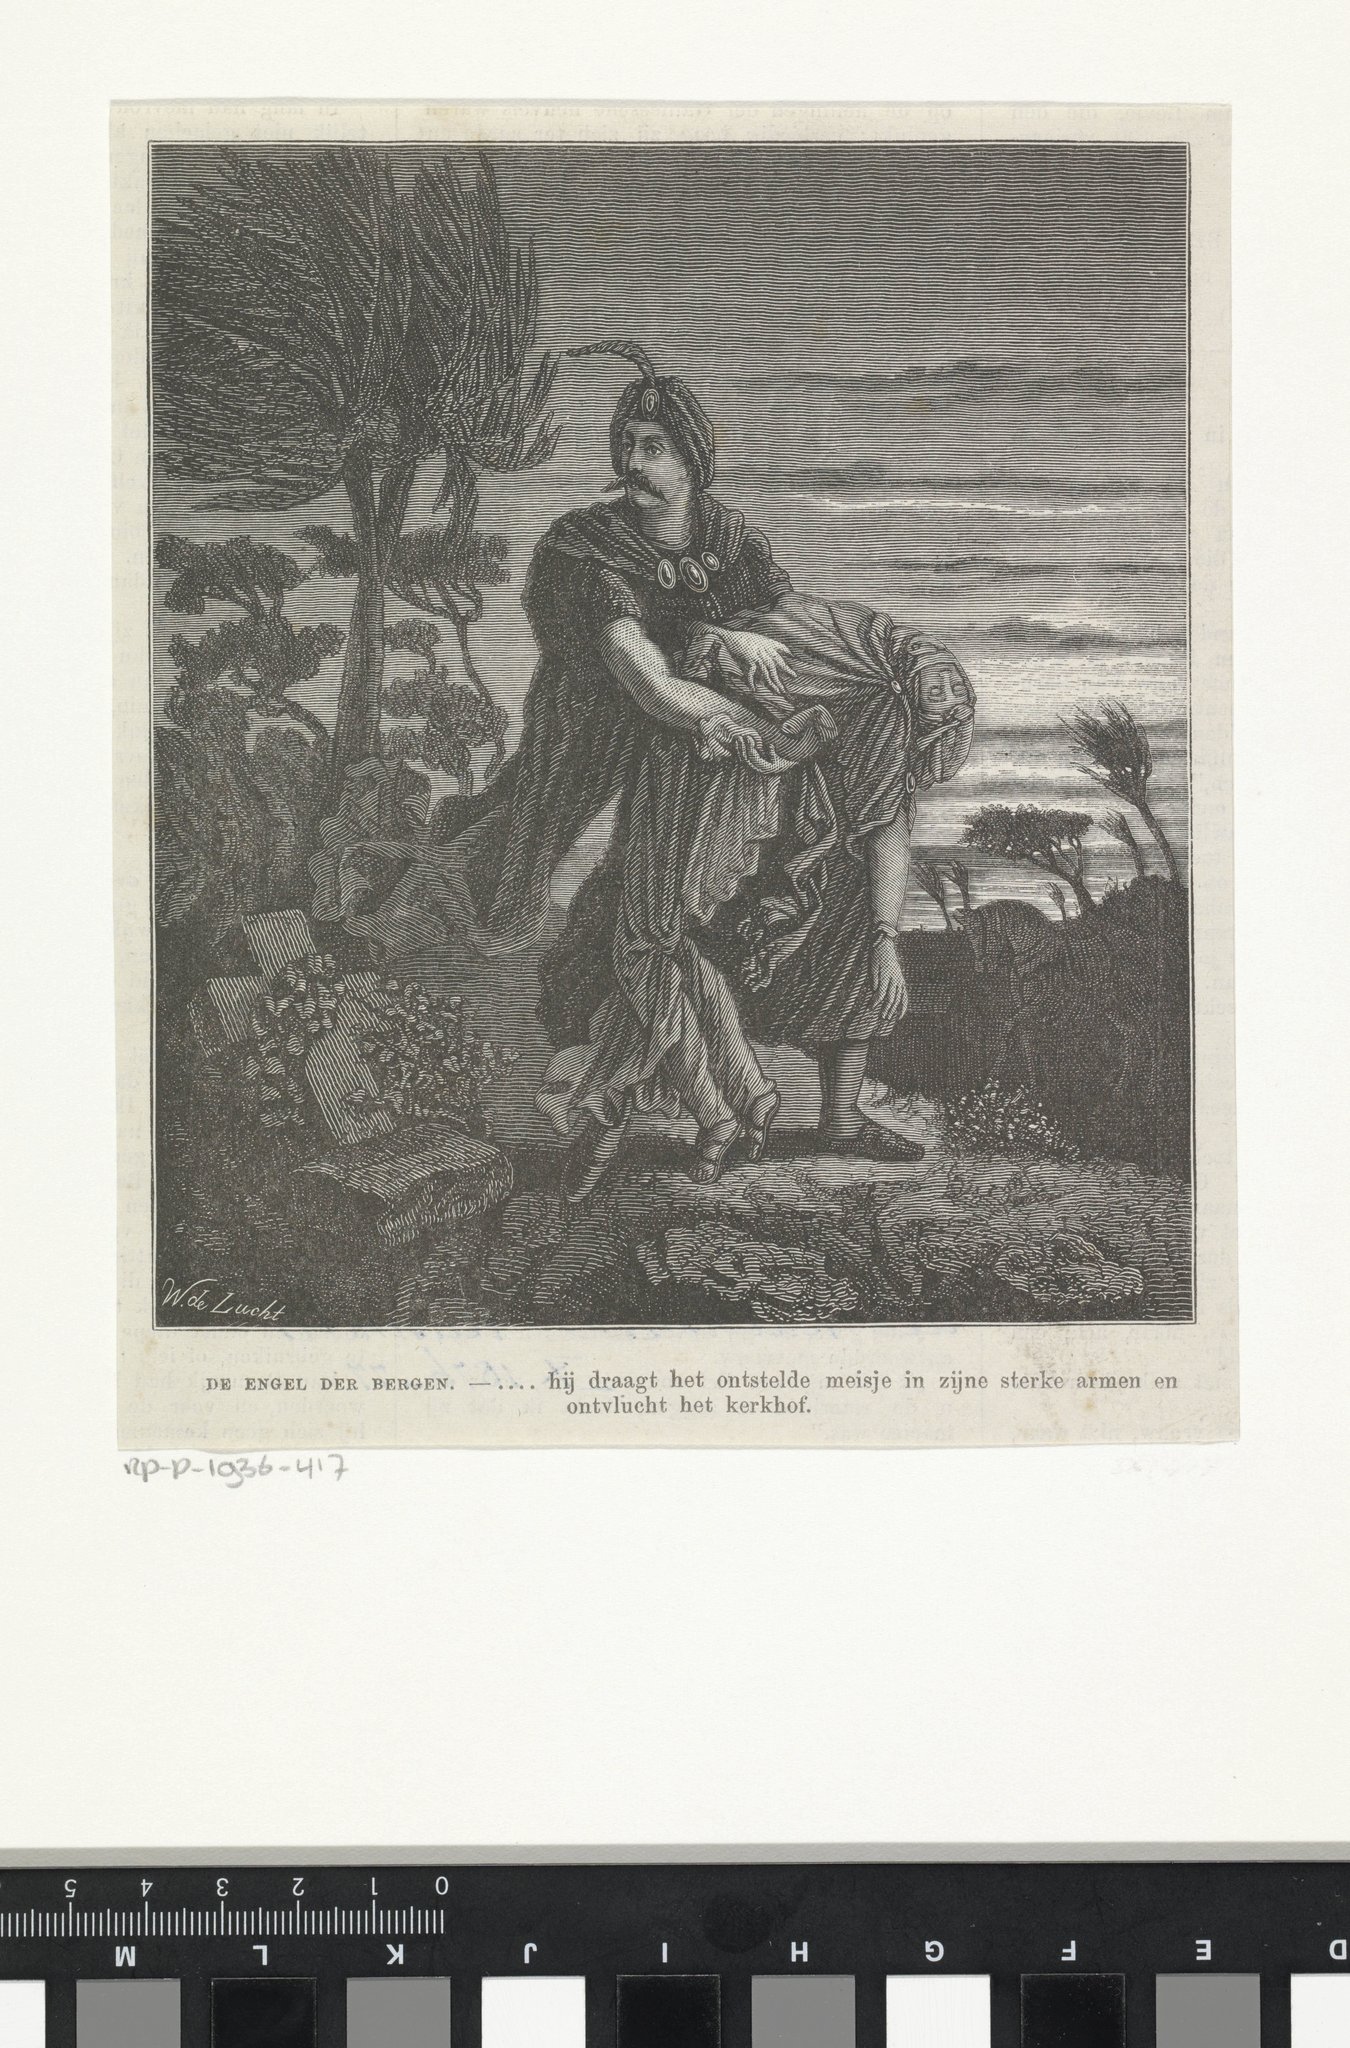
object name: print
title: De engel der bergen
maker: willem de lucht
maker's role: print maker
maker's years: 1849-1895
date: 1876-1877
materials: paper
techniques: letterpress printing, engraving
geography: netherlands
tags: head-gear: turban, unconsciousness, horse, churchyard, cemetery, veil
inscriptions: collector's mark: Lugt 2228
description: Een man met een tulband draagt een gesluierd, bewusteloos meisje een kerkhof uit. Op de achtergrond staat een paard.